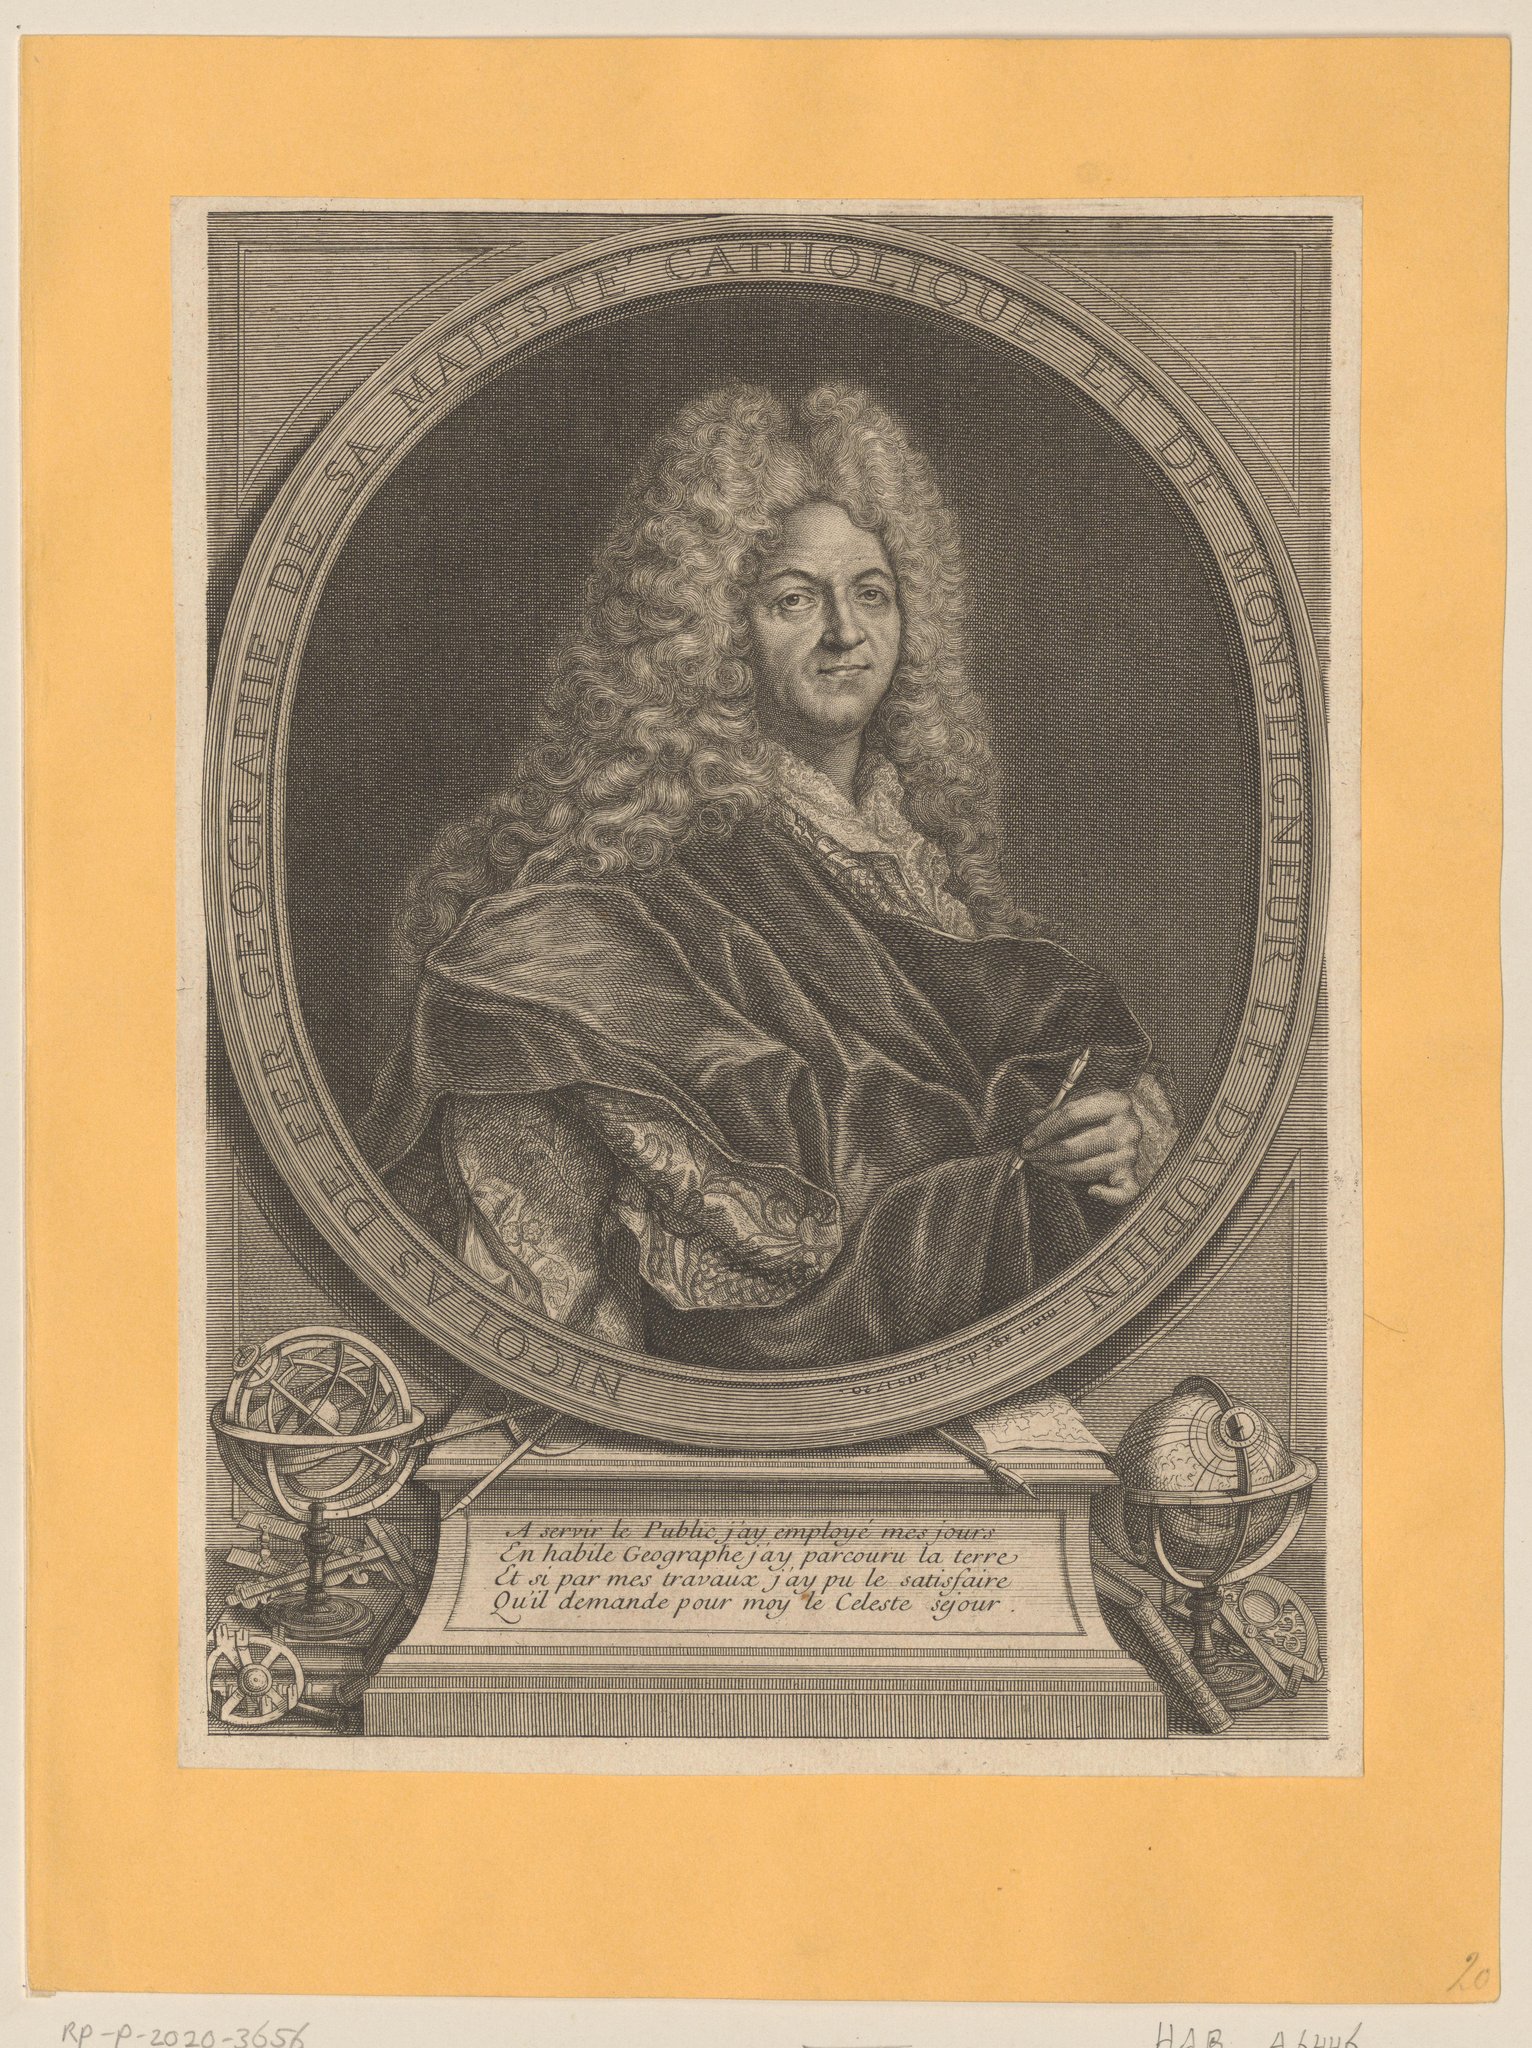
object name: print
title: Portret van Nicolas de Fer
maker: Anonymous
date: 1720-1750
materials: paper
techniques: engraving, etching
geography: france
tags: publisher, nicolas de fer, historical persons, geography (+ portrait of scholar, scientist), armillary sphere, skeleton celestial globe, globe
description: Met vierregelig vers in het Frans onder het portret.